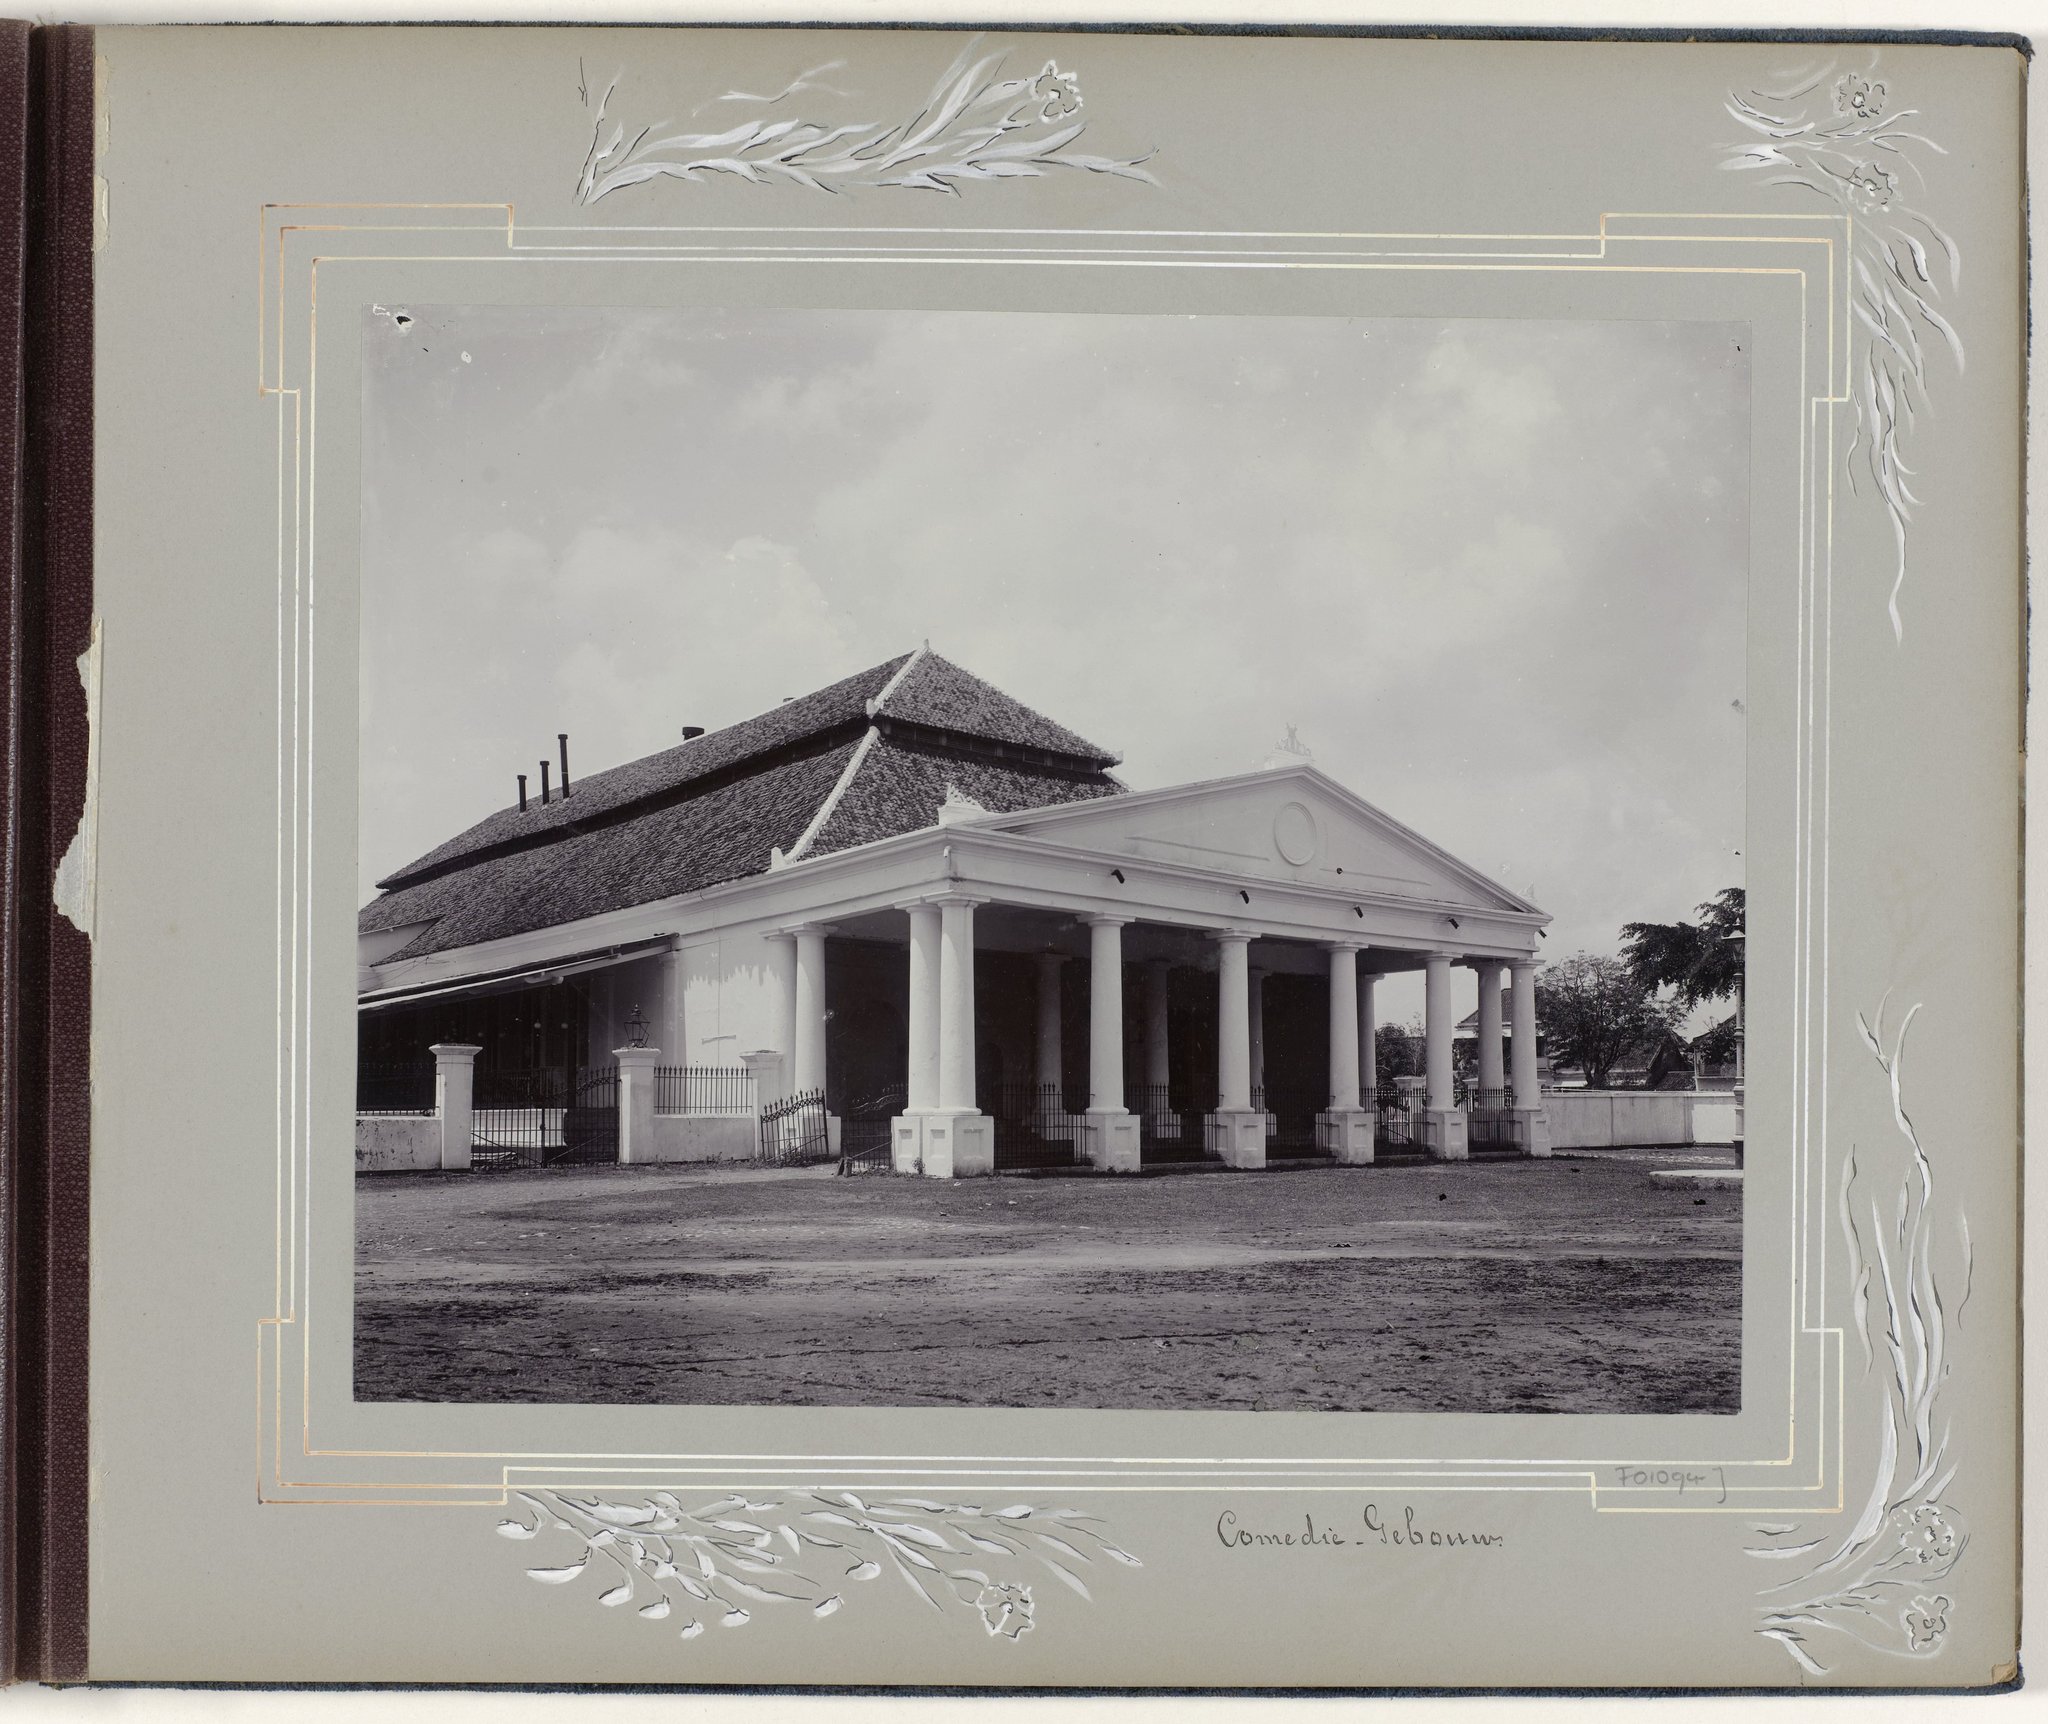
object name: album leaf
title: Exterieur van het Comediegebouw van Soerabaja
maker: Anonymous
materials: cardboard, paper, photographic support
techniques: gelatin silver print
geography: surabaya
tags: theatre (building), surabaya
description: Onderdeel van Herinneringsalbum met foto's van Soerabaja.